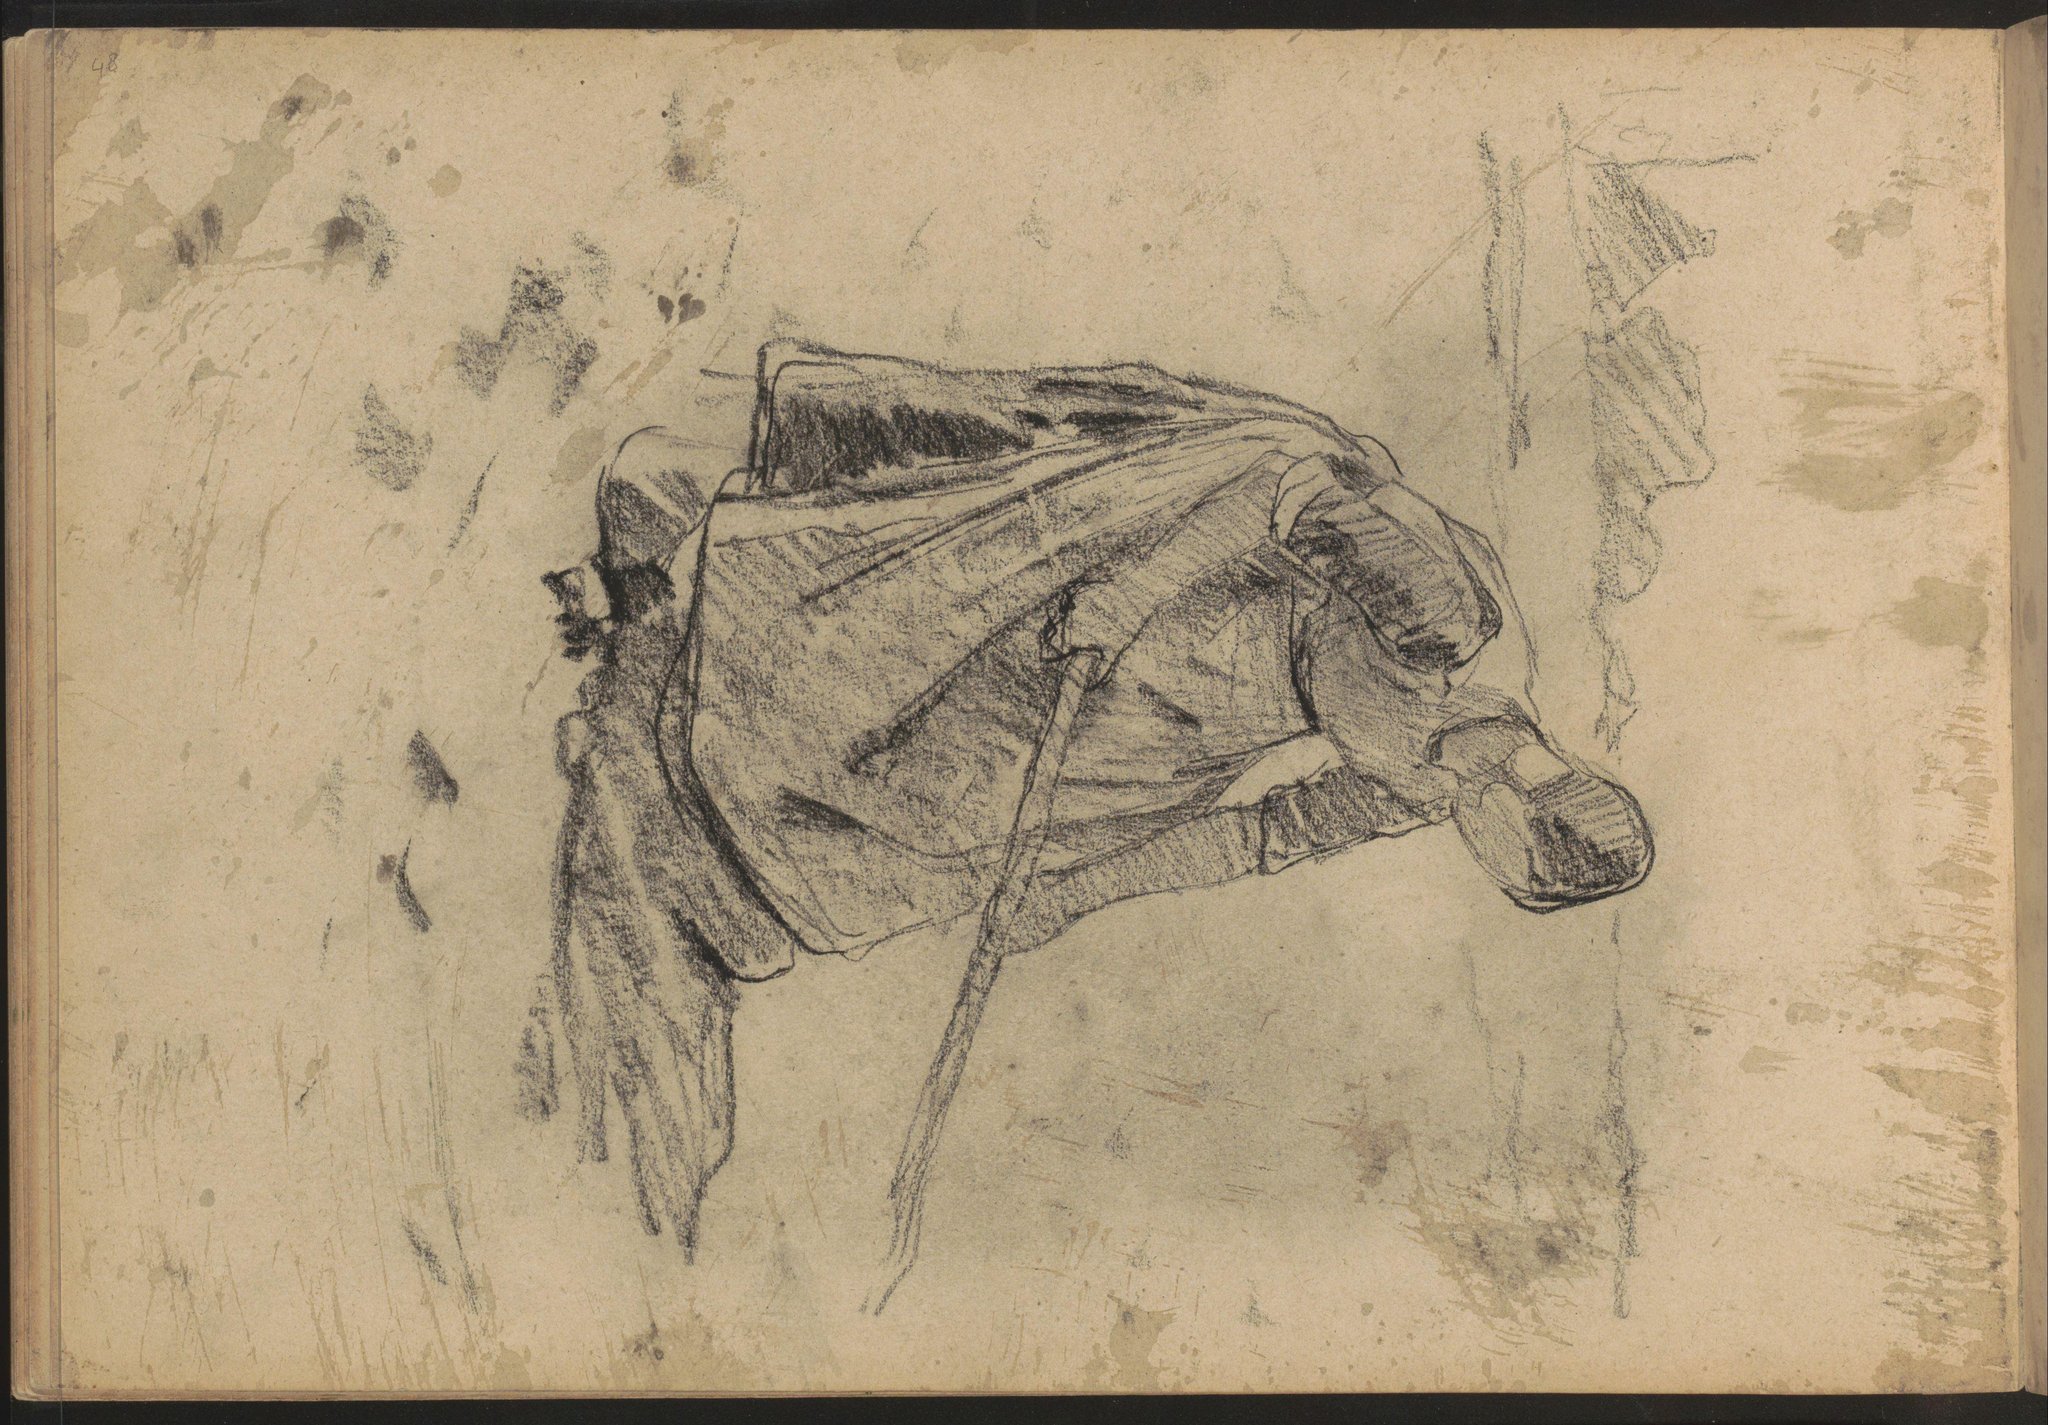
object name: sketchbook leaf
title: Boerin met schoffel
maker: willem witsen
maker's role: draughtsman, painter, print maker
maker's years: 1860-1923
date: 1884-1887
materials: chalk, paper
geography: ewijkshoeve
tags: cultivation ~ agriculture (+ women (labourers))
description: Voorstudie voor de ets 'Boerin met schoffel, naar links gewend', ca. 1886-1887.